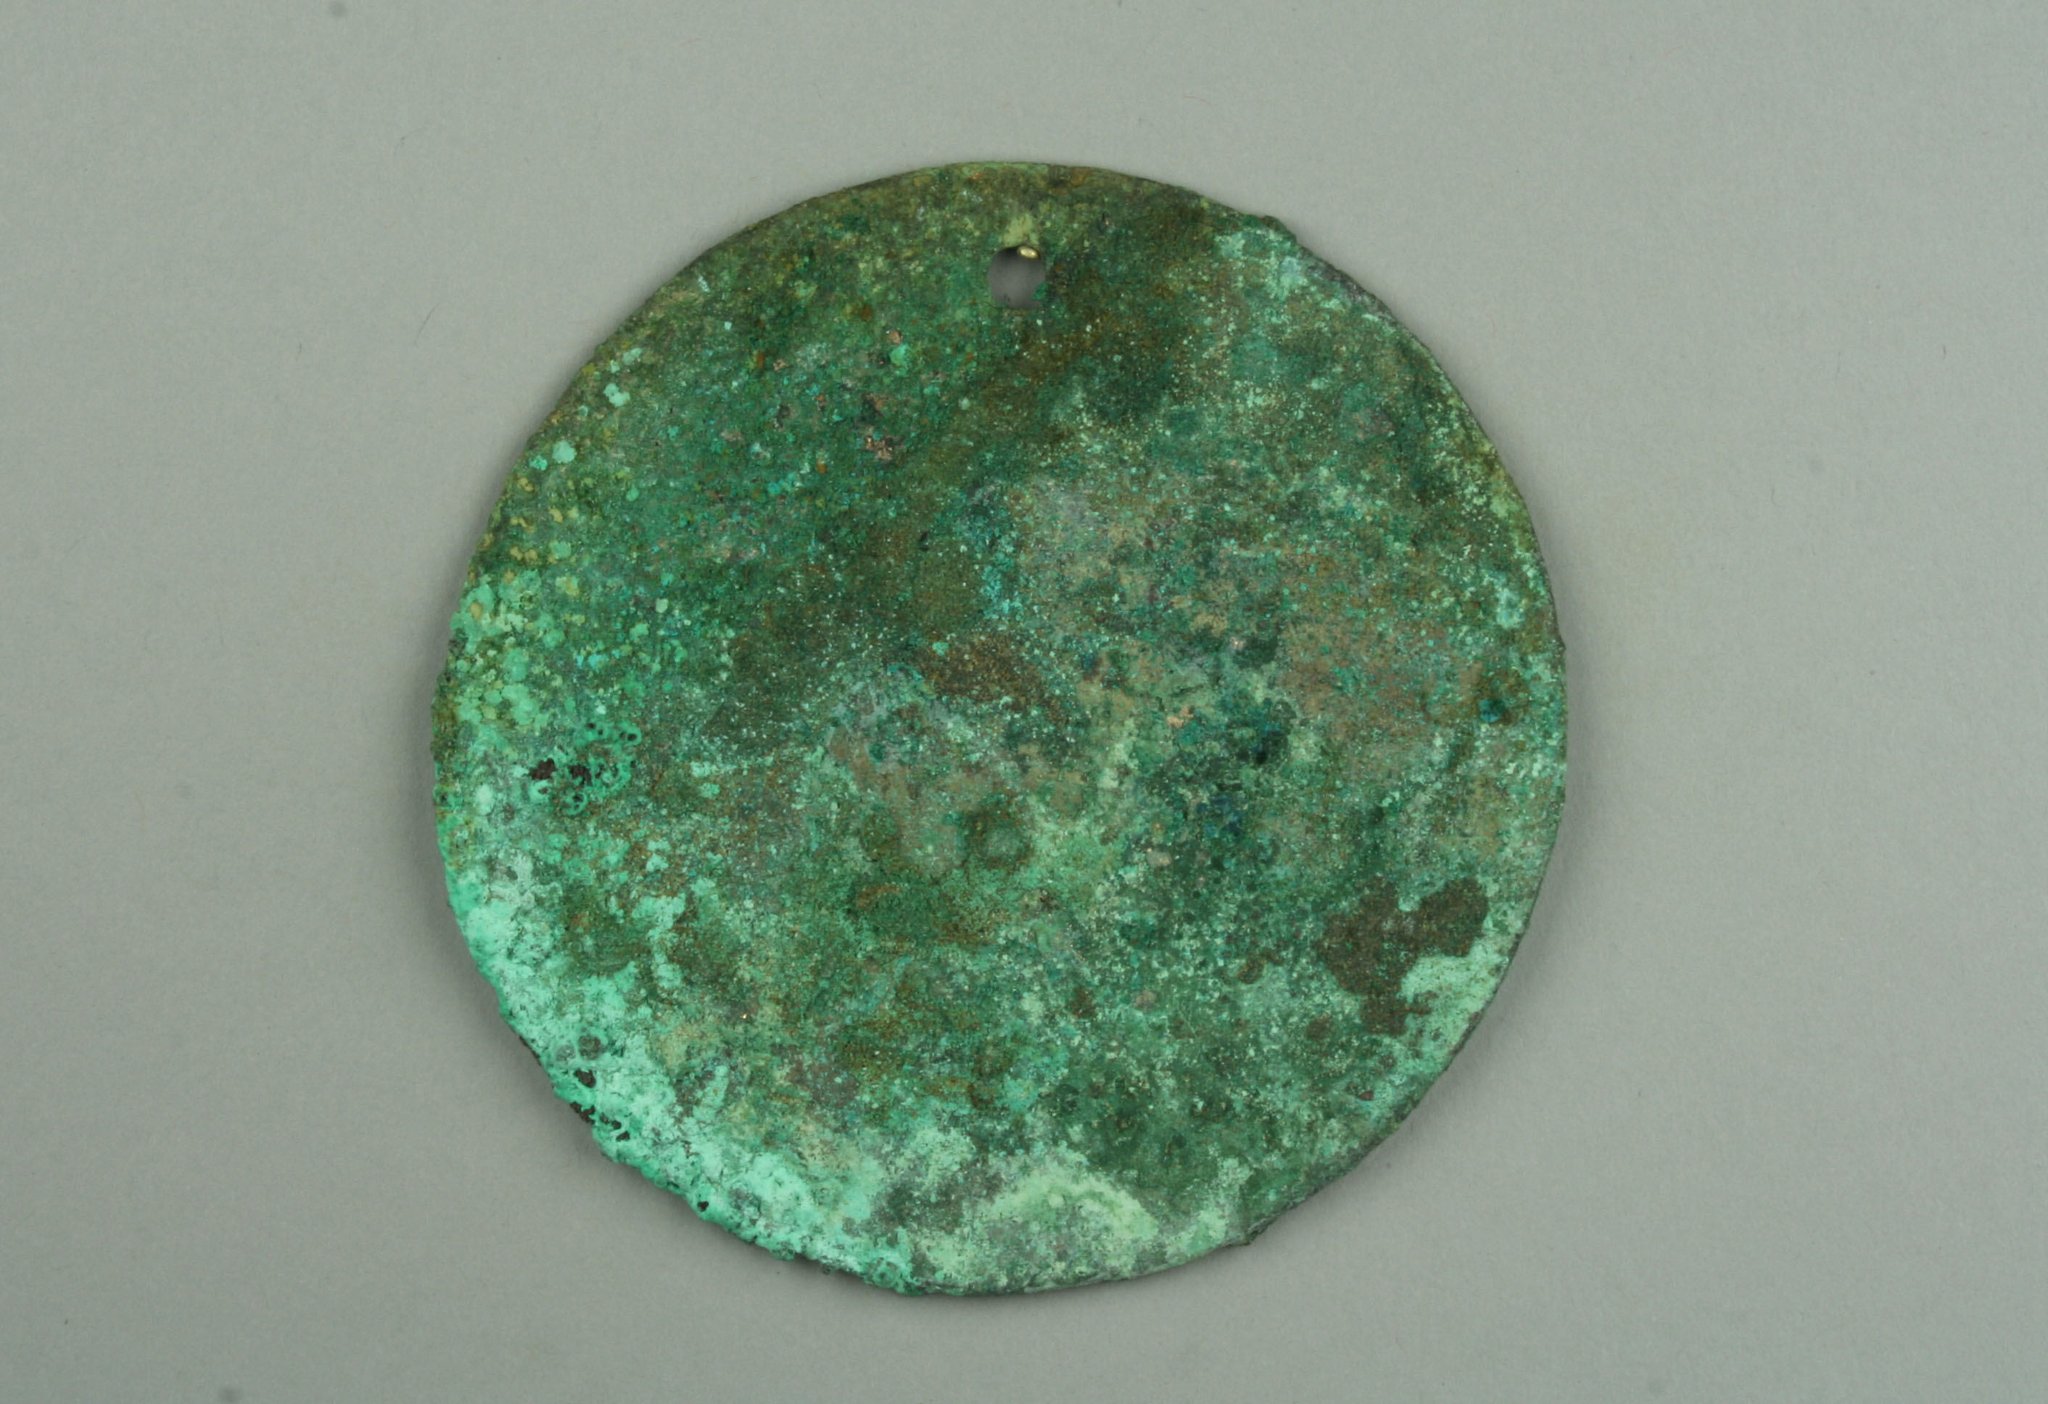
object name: plaque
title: Round Plaque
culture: vicús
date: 300 BCE-200 CE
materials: copper, gilt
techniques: hammering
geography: peru